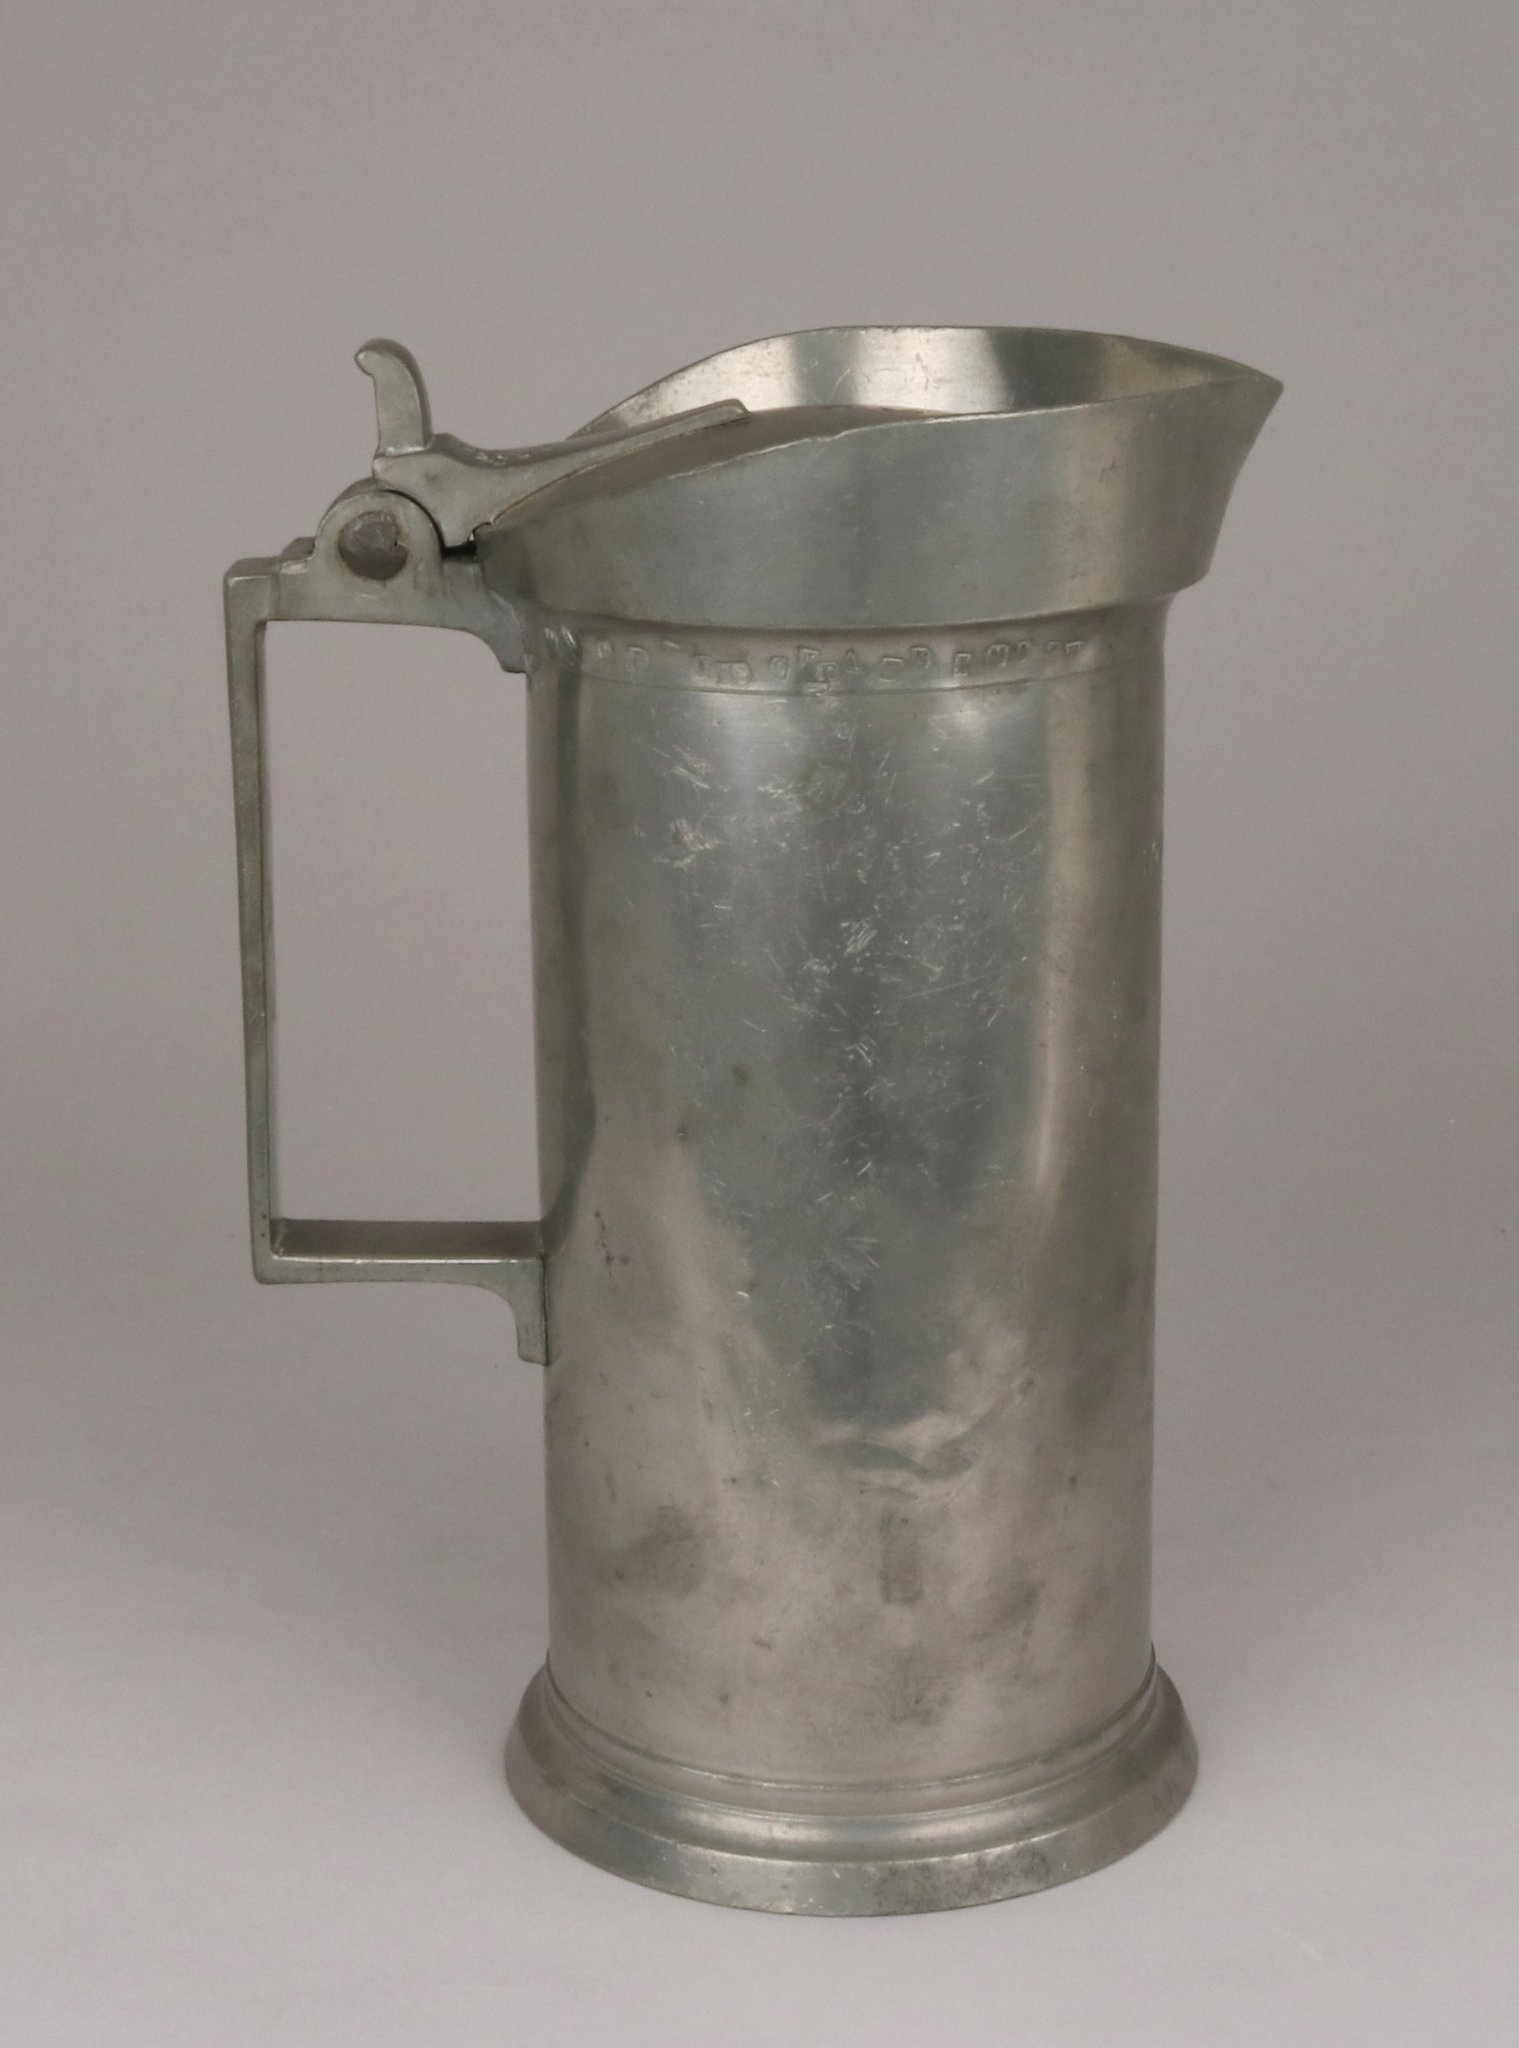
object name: measure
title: Double litre measure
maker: e. boulanget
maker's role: maker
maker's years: 1750-1850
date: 1867-1900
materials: pewter